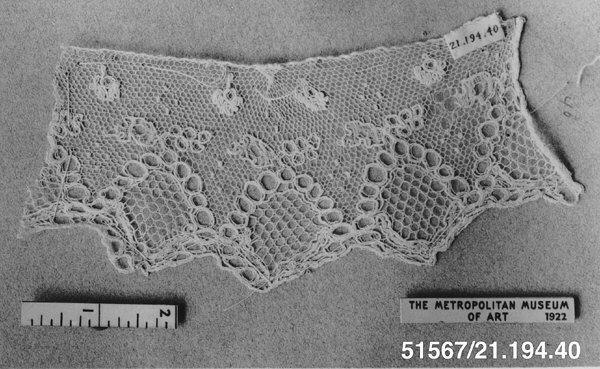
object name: piece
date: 1801-1900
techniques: lace